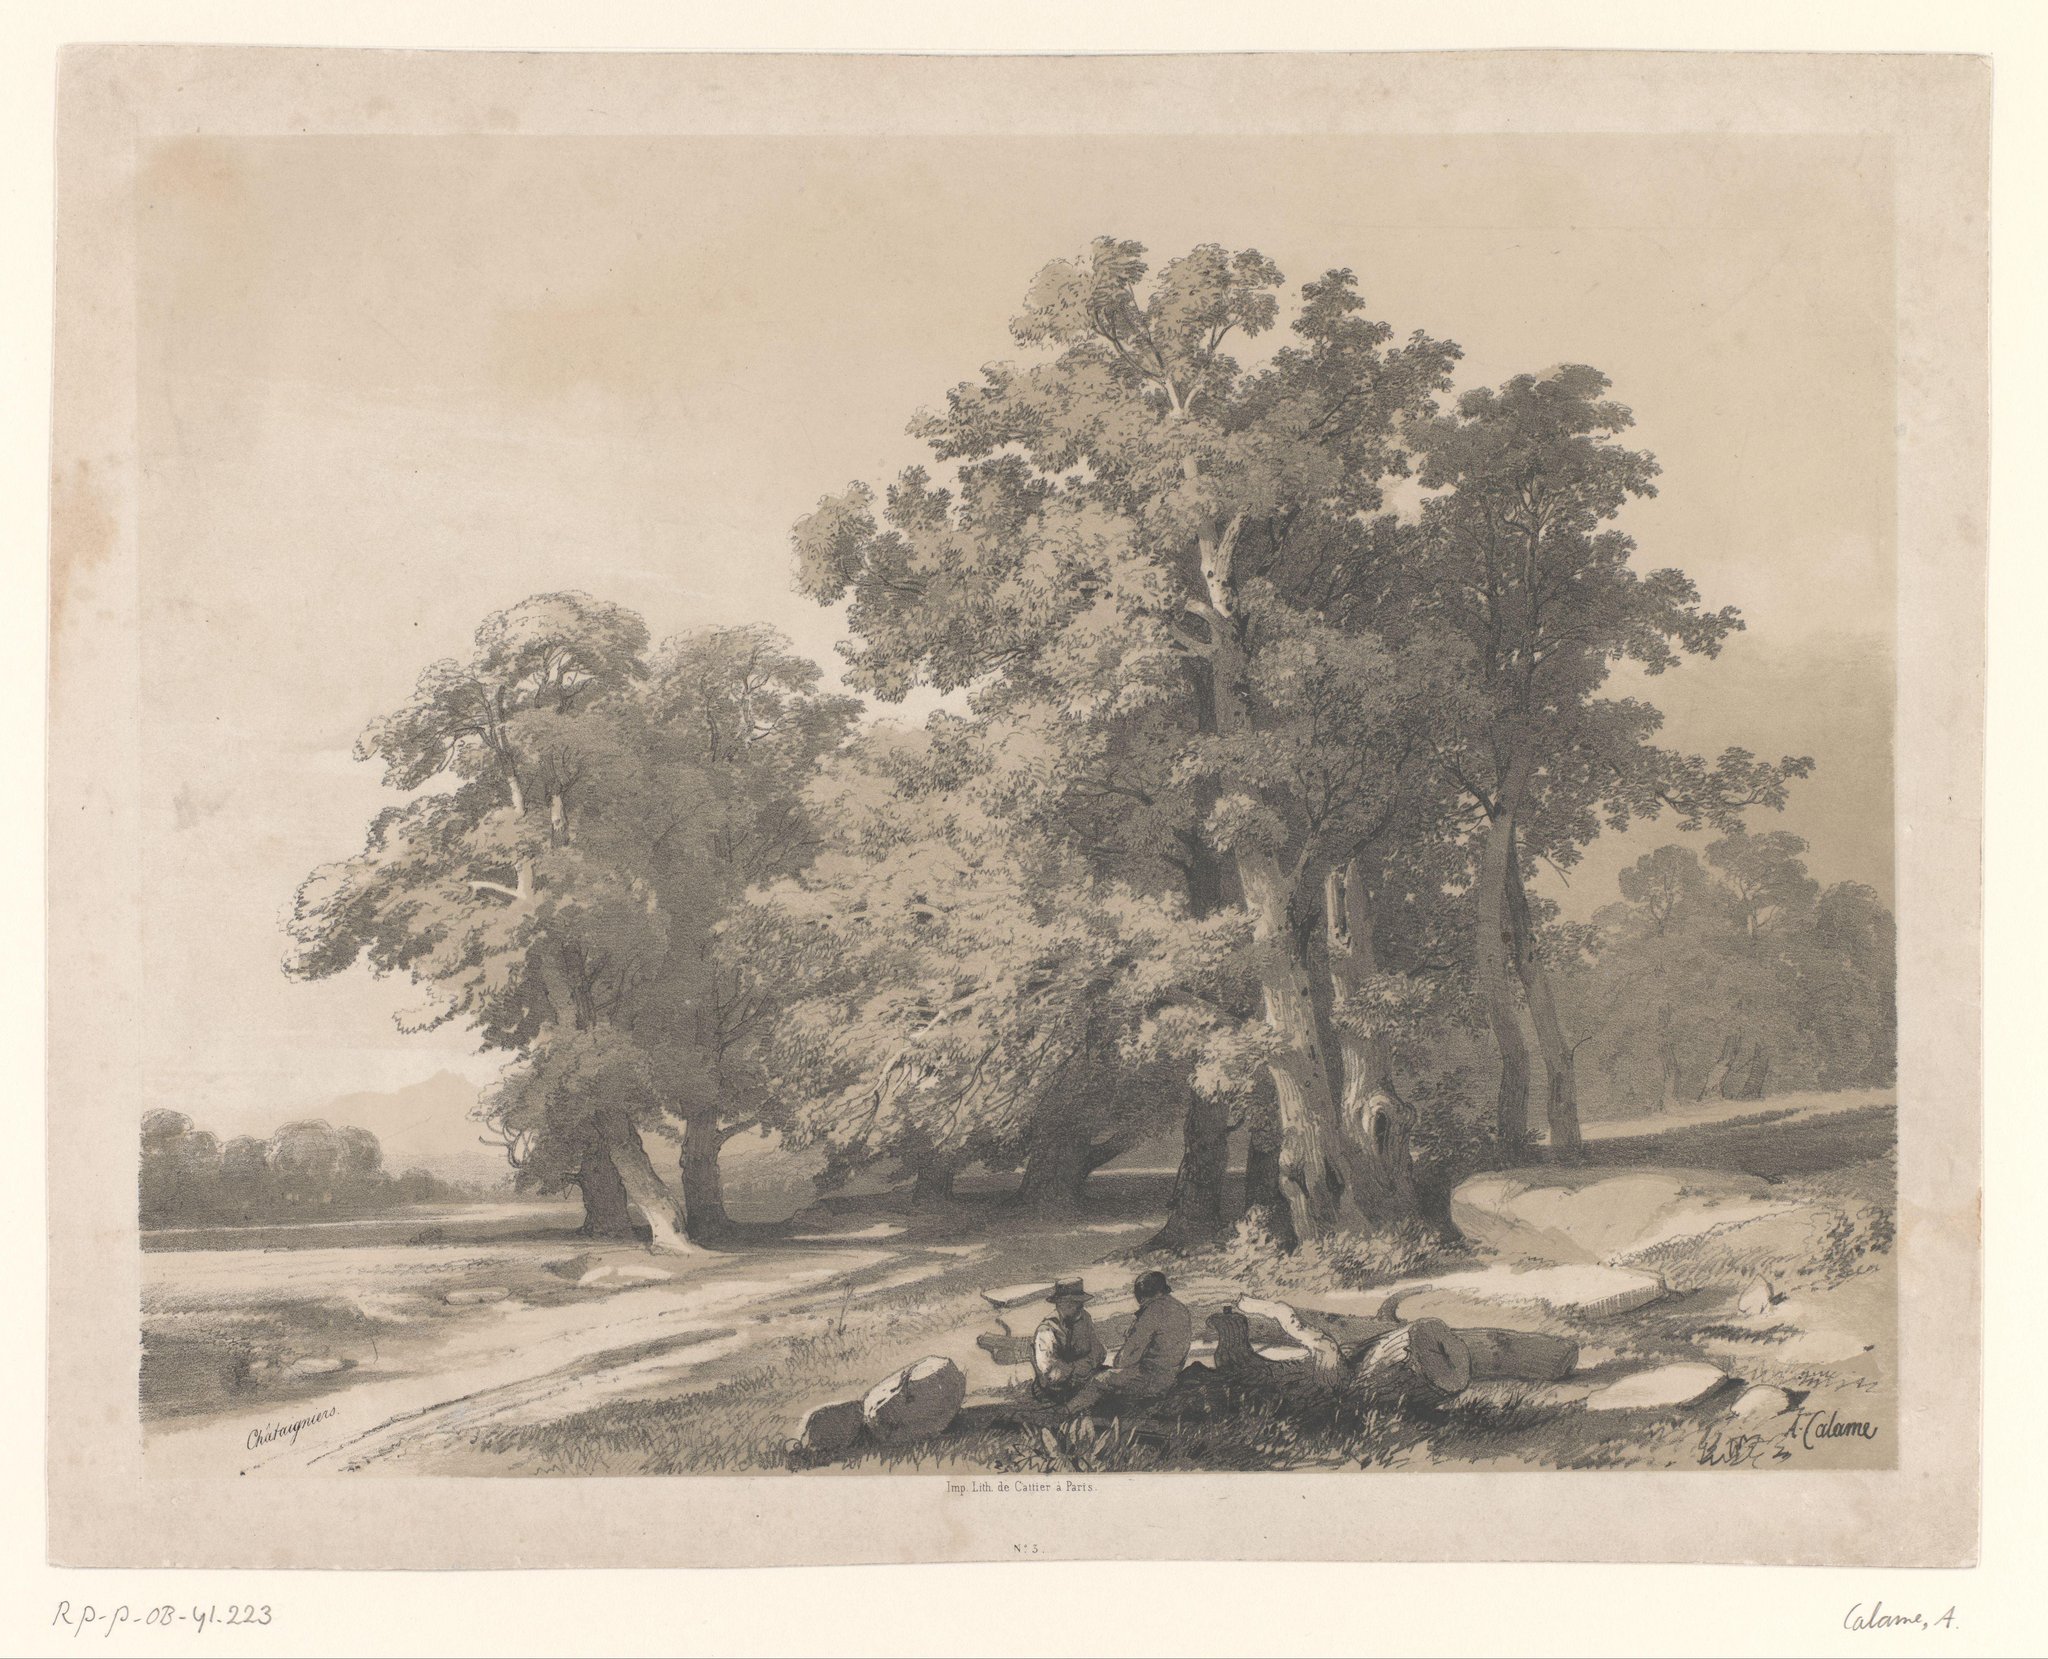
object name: print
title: Landschap met kastanjebomen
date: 1842-1856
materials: paper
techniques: lithograph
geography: paris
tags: trees: chestnut-tree (leaves, putting forth leaves), mountains (+ landscape with figures, staffage)